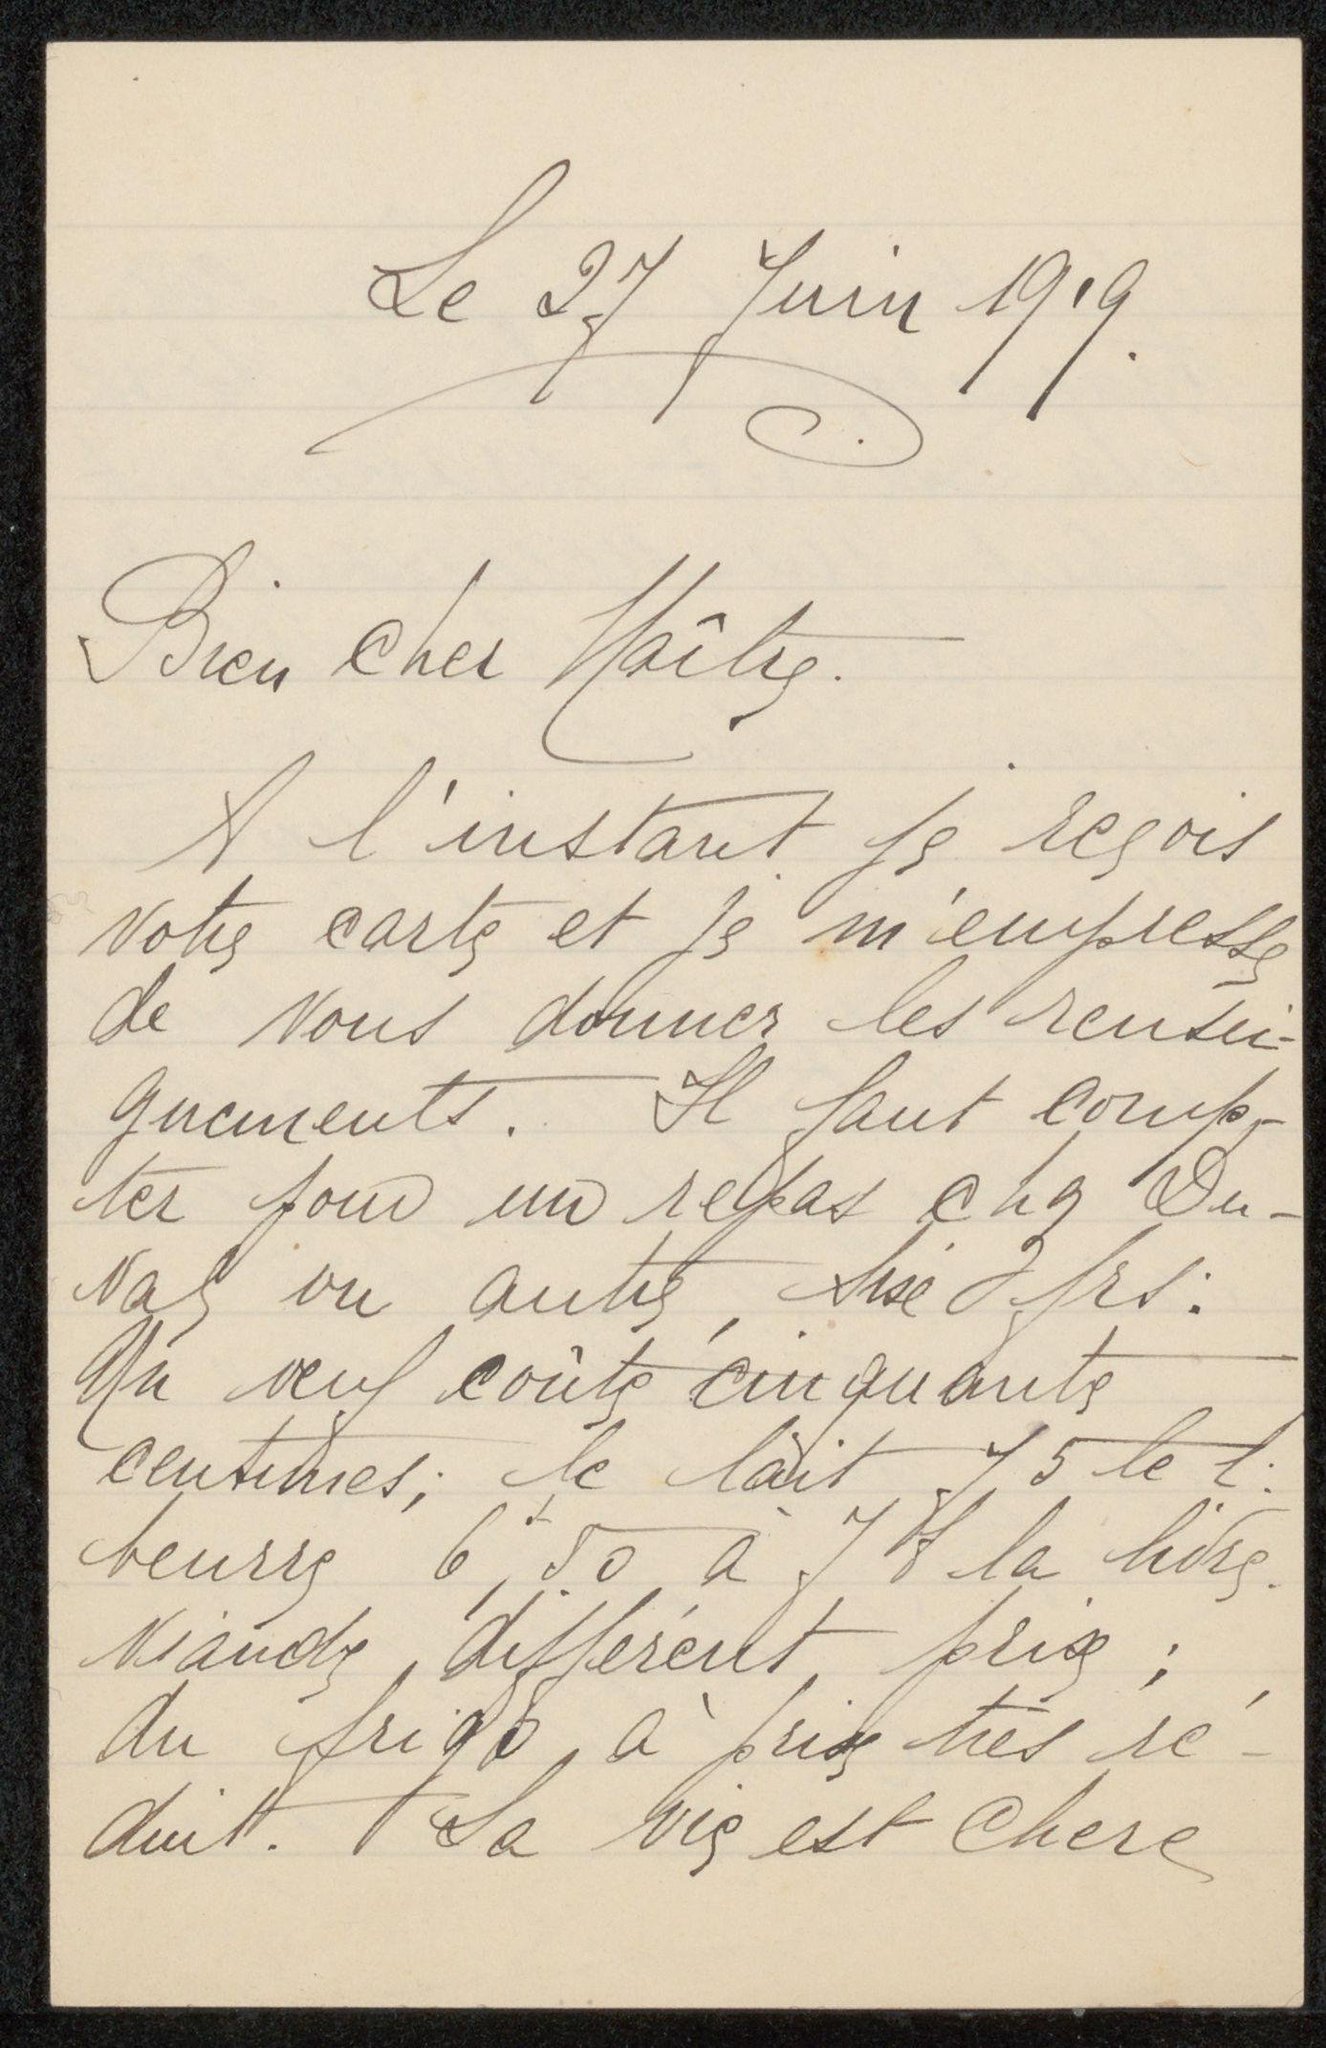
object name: letter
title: Brief aan Philip Zilcken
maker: rose imel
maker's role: draughtsman, painter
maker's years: 1901-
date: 1919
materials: ink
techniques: pen, writing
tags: the hague, painter, draughtsman, philip zilcken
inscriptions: collector's mark: ‘RPK’